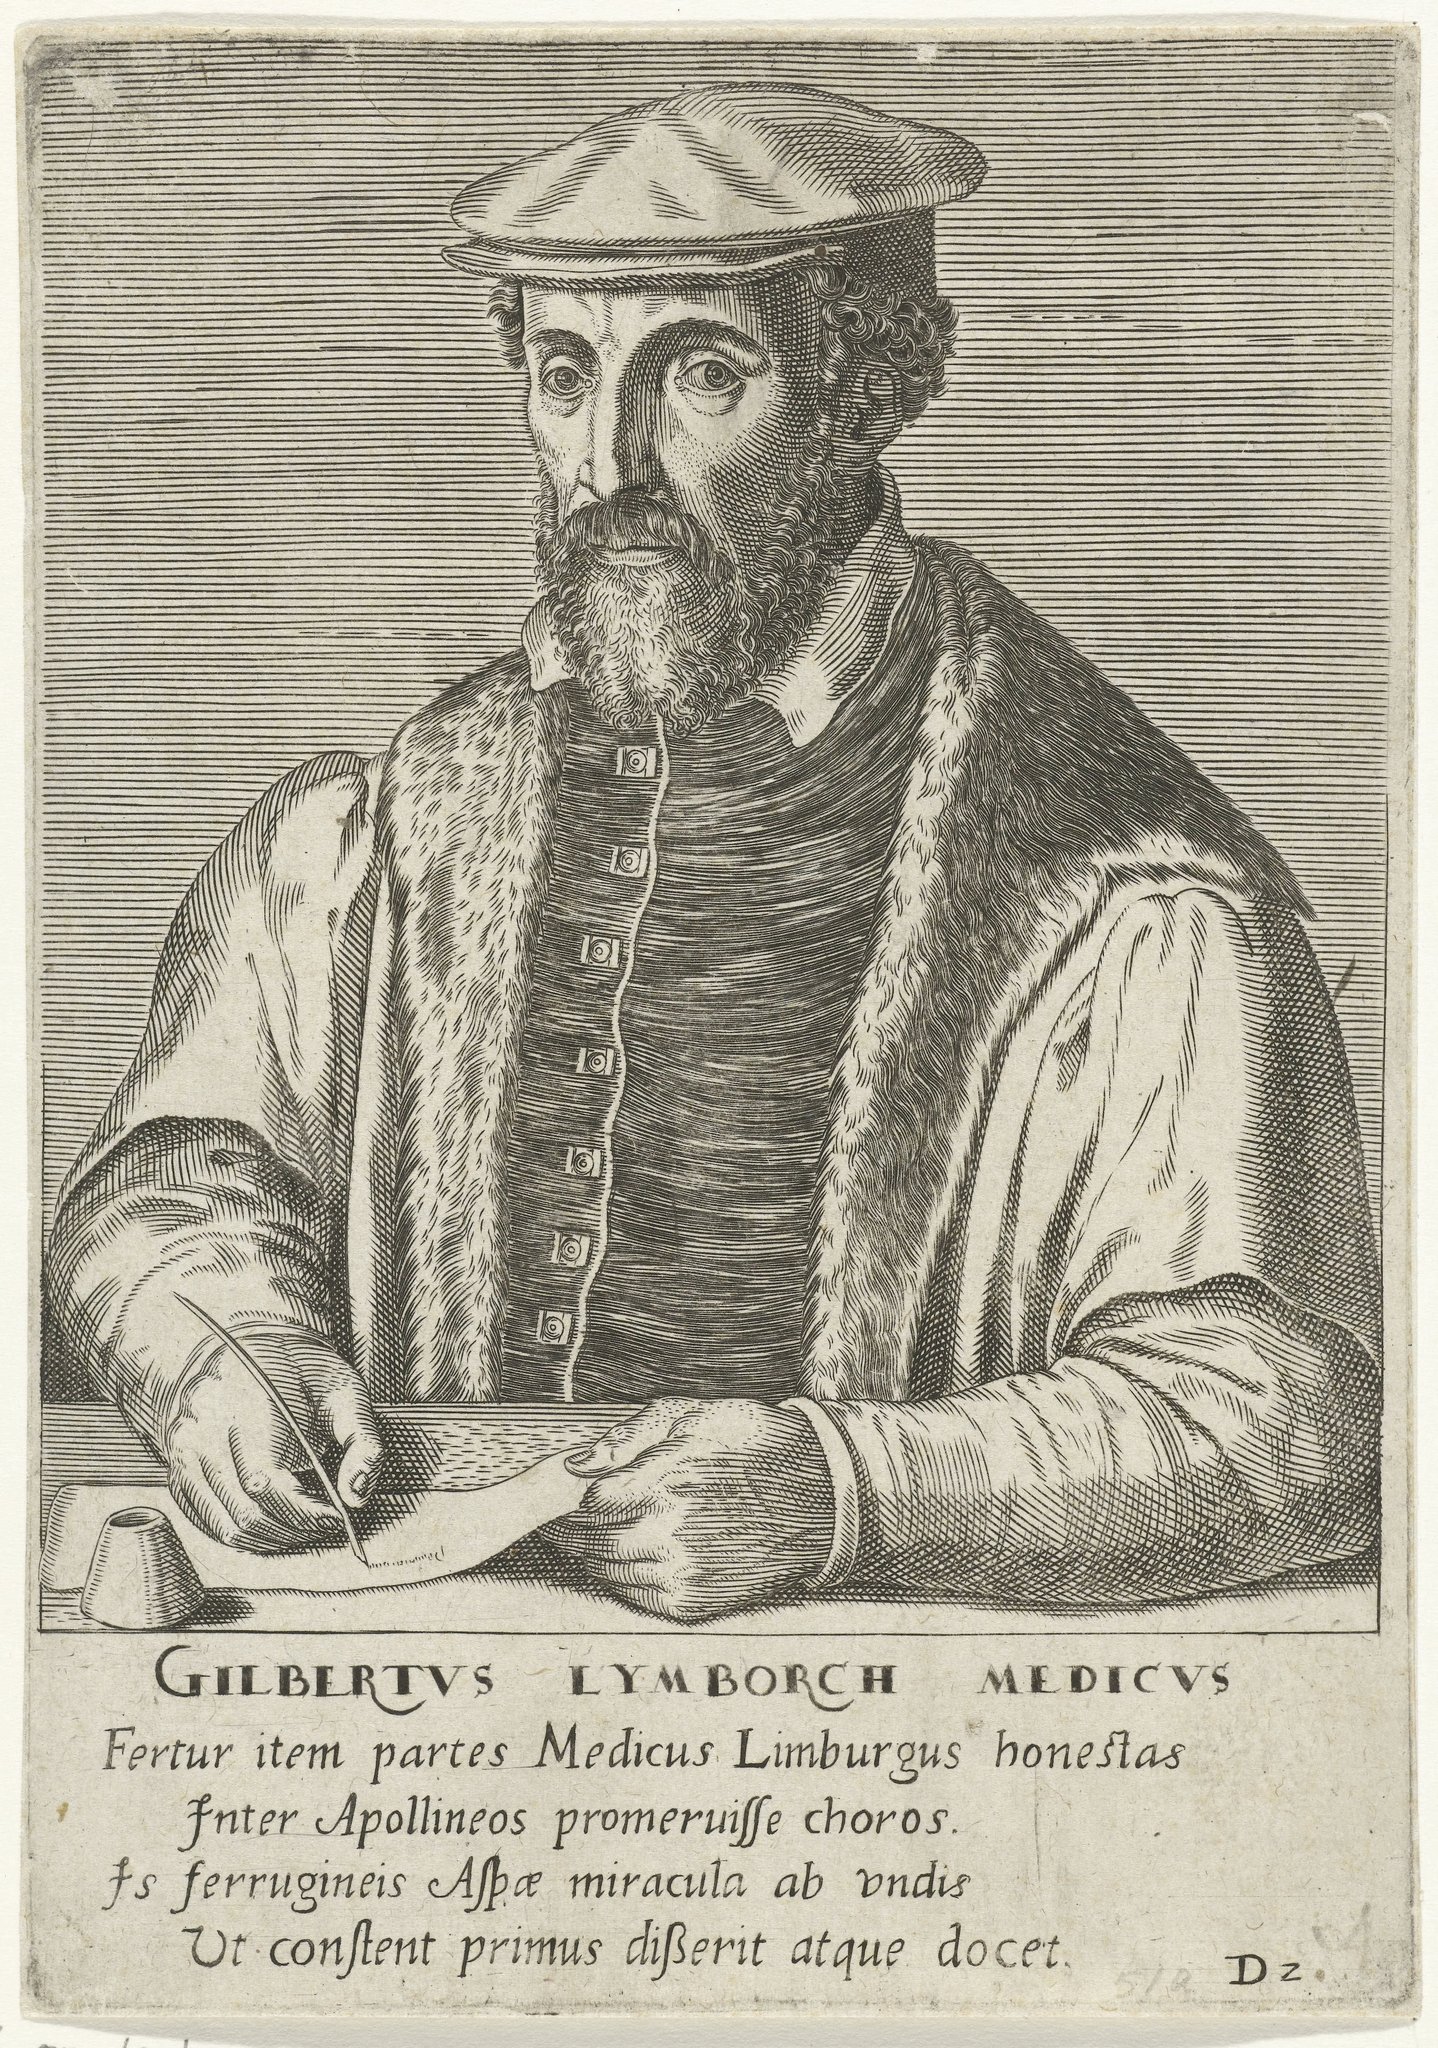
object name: print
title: Gilbertvs Lymborch medicvs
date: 1572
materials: paper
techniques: engraving, letterpress printing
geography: antwerp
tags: limburg (belgische provincie), arts, gilbert fusch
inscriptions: collector's mark: Lugt 2228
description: Portret van Gilbert Fusch, Limburgse humanist en arts. Buste naar links. Genummerd D2. De prent heeft een Latijns onderschrift en maakt deel uit van een serie van beroemde Europese geleerden.